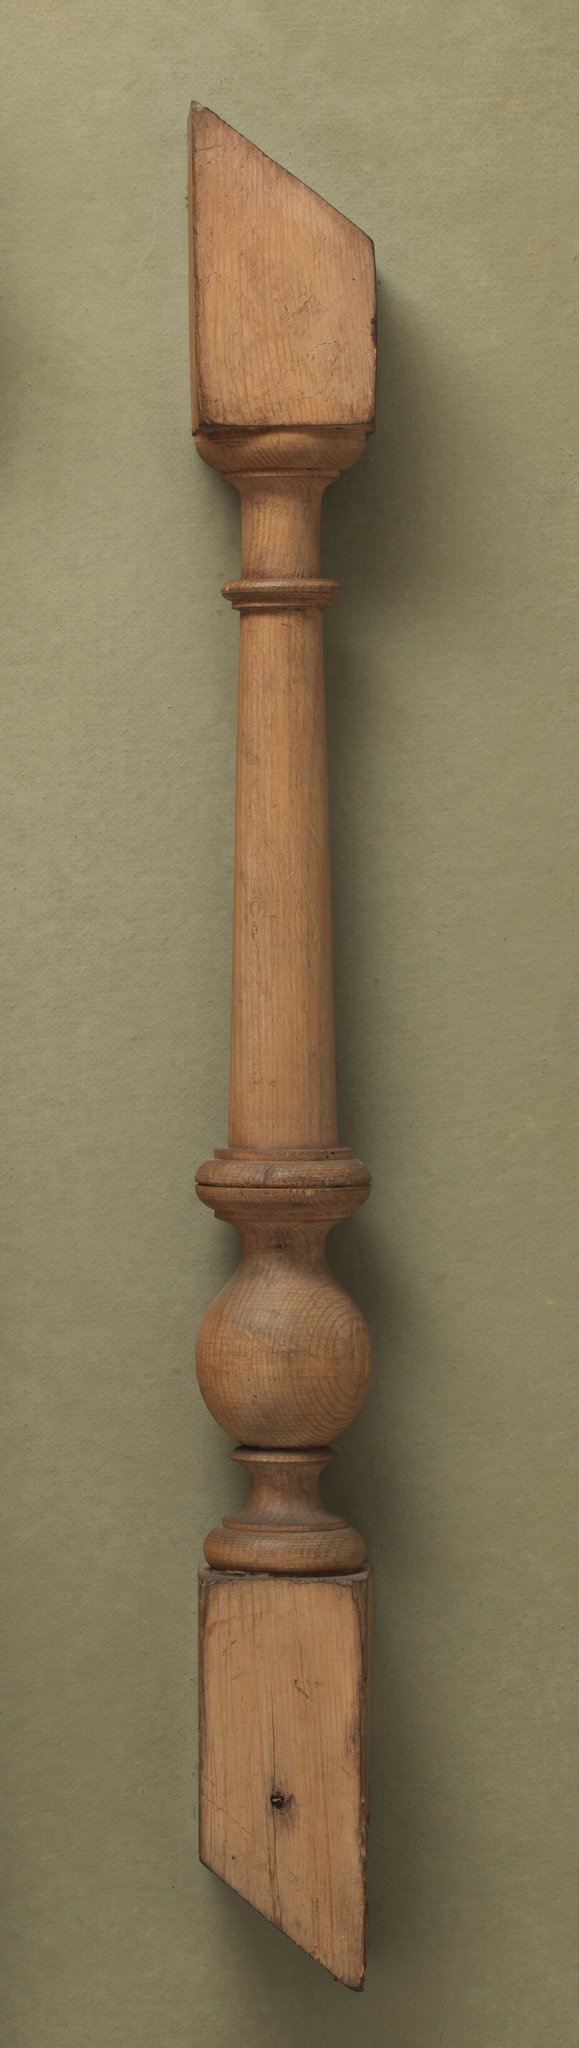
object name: baluster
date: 1701-1750